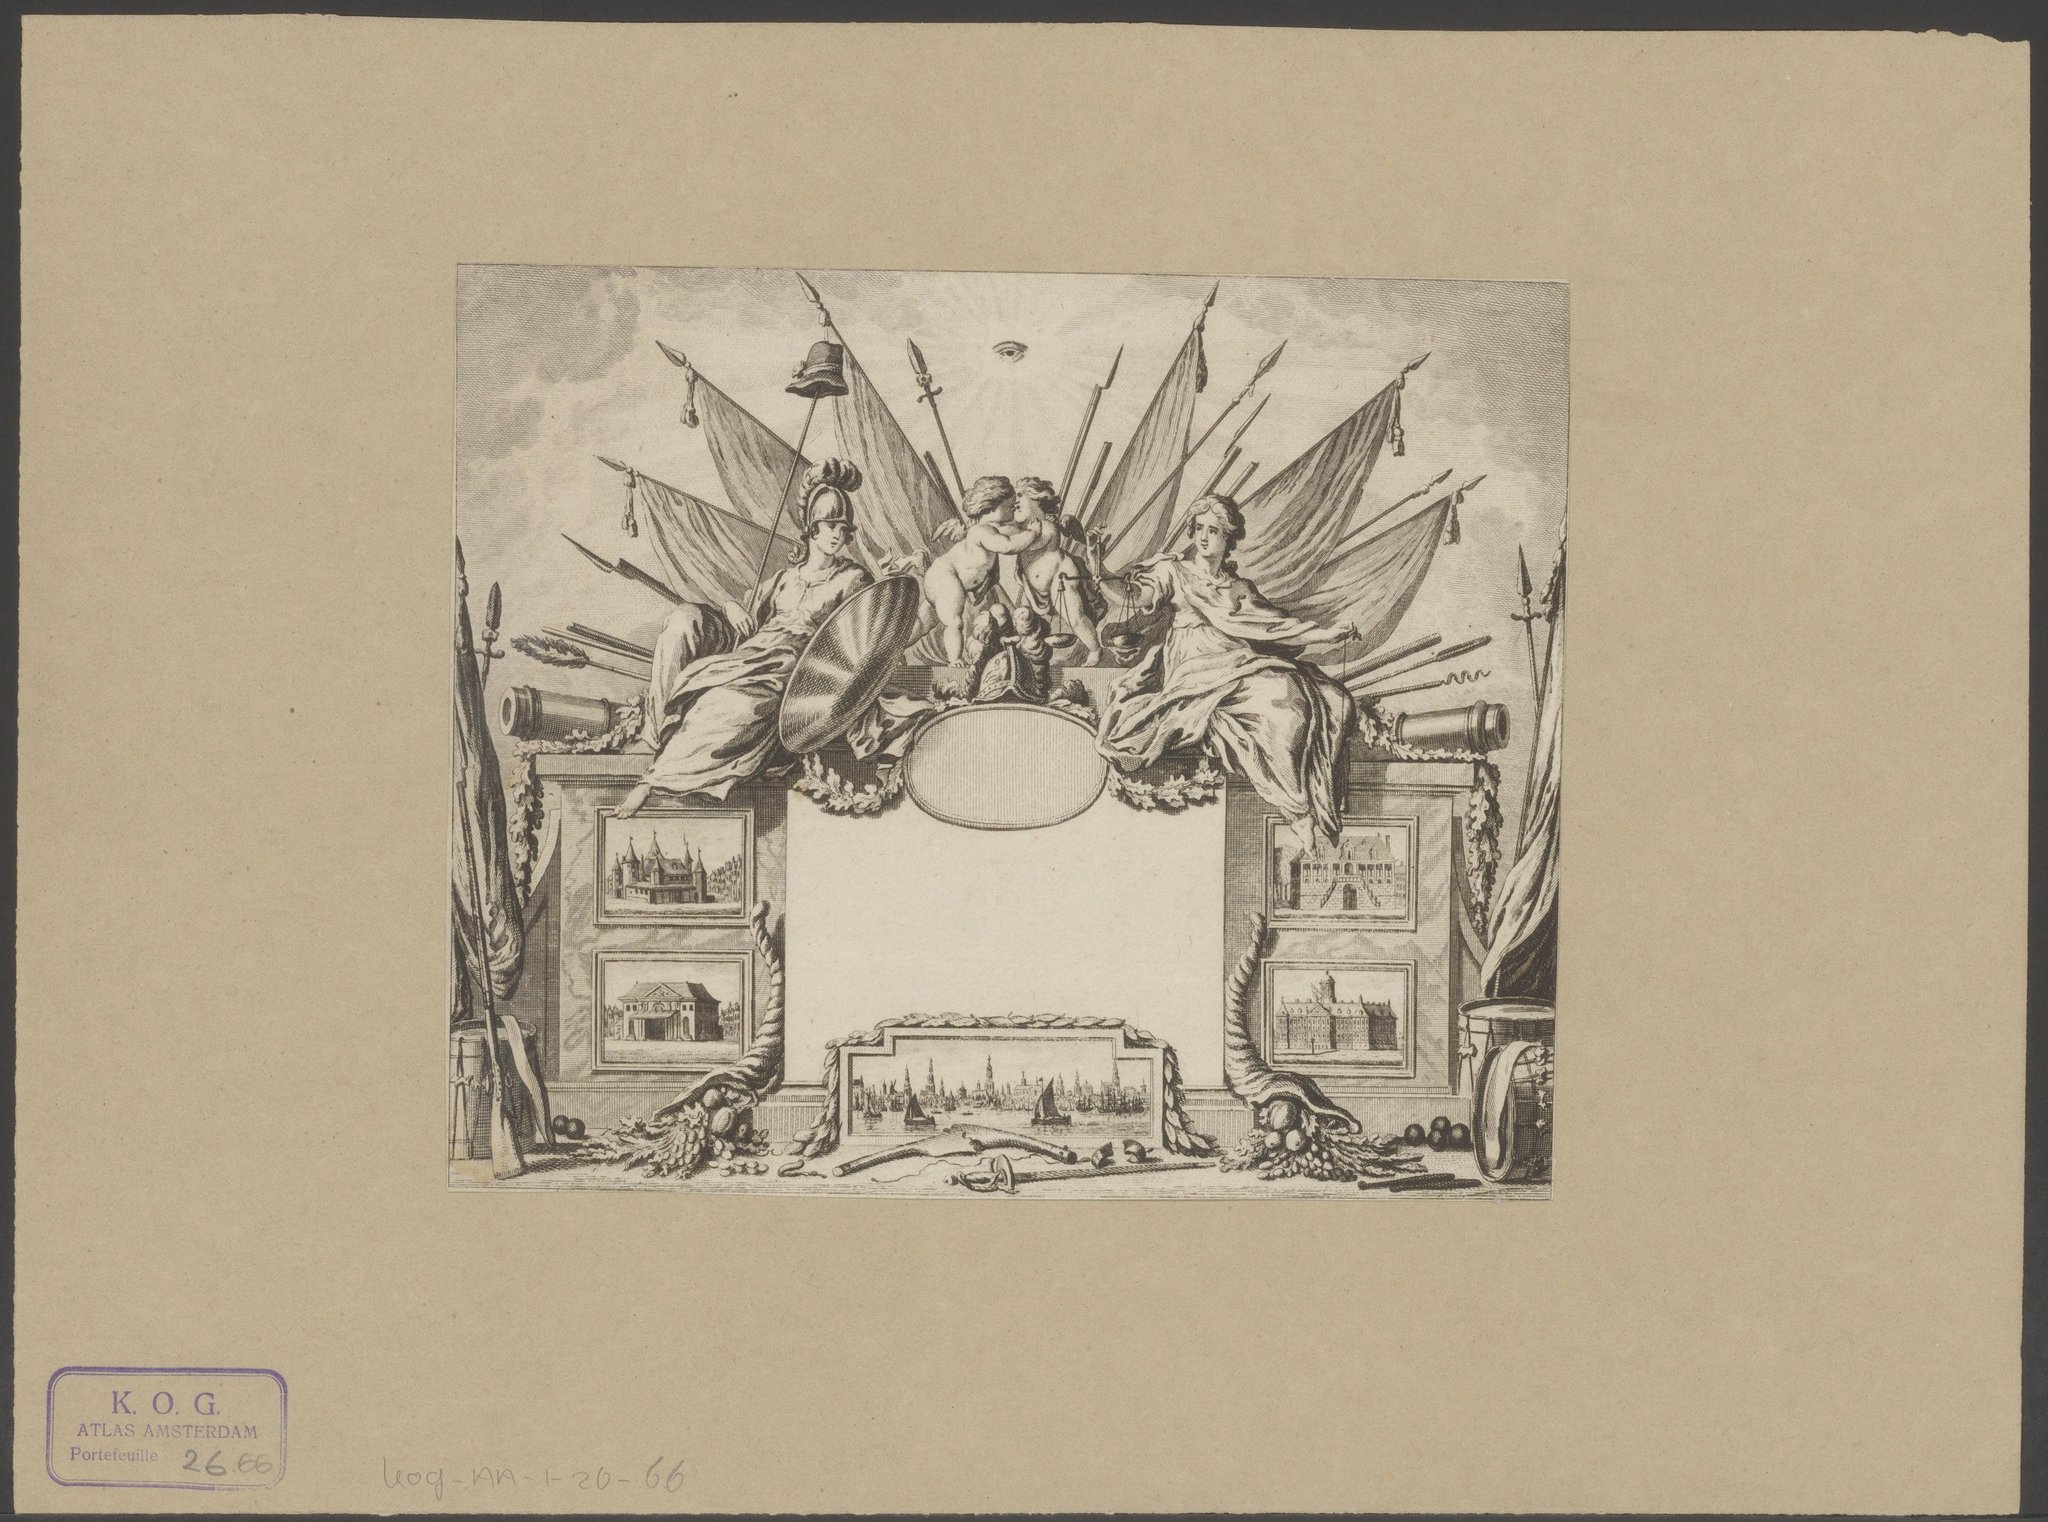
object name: print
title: Schuttersbrief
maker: Anonymous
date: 1701-1800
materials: paper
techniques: etching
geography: northern netherlands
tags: the all-seeing eye, triangle with eye ~ symbol of god the father, freedom, liberty; 'libertà' (ripa), civic architecture; edifices; dwellings, cupids: 'amores', 'amoretti', 'putti', prospect of city, town panorama, silhouette of city, equality, equity, fairness, righteousness; 'equalità', 'equità', 'giuditio giusto', 'ordine dritto e giusto', 'ugualità' (ripa), amsterdam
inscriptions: collector's mark: Lugt 1641b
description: Onderwerpsrubriek binnen de Atlas Amsterdam: Schutters-oproepingsbriefjes.